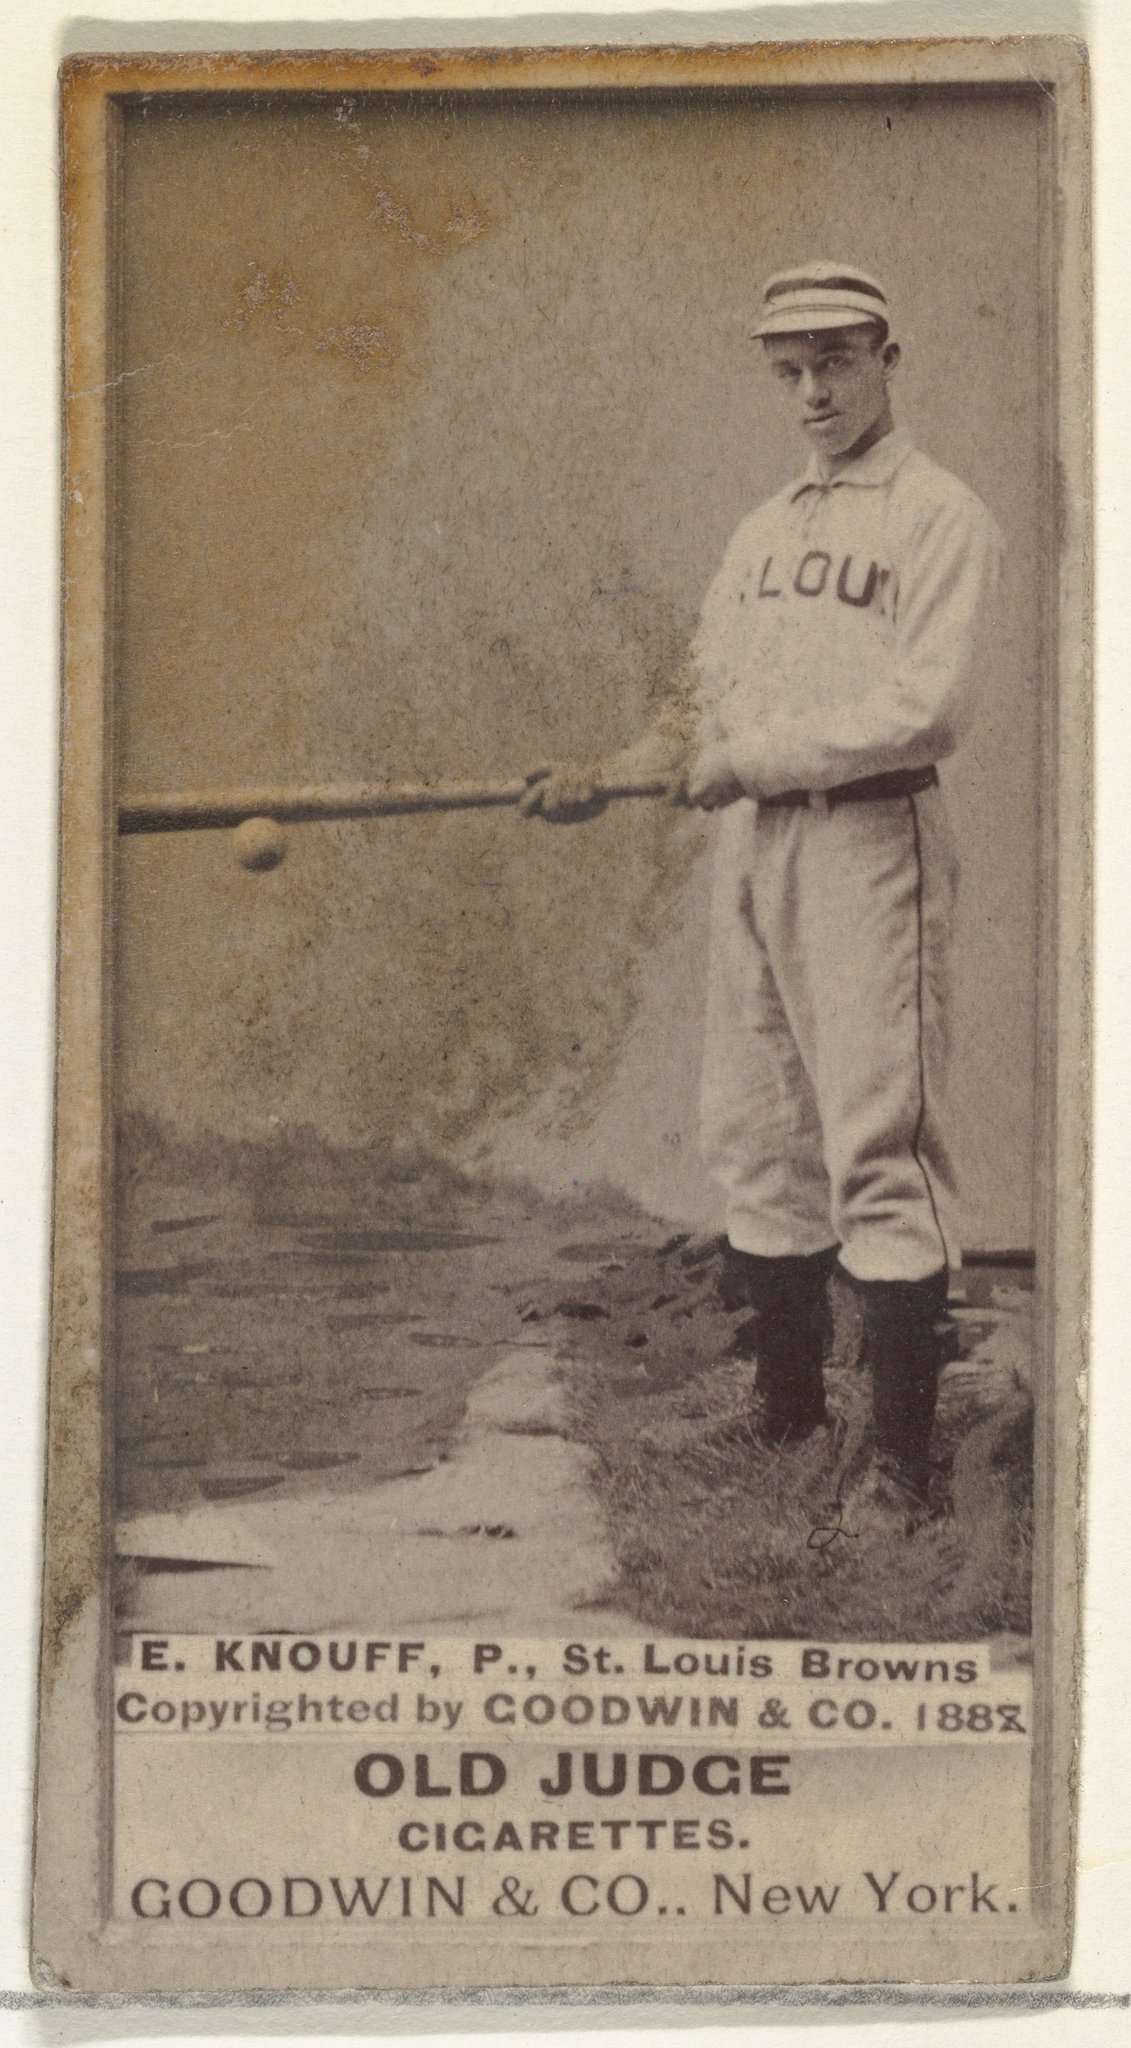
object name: baseball card, photograph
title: Edward Augustine "Ed" Knouff, Pitcher, St. Louis Browns, from the Old Judge series (N172) for Old Judge Cigarettes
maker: goodwin & company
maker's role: publisher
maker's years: 1850-1950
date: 1888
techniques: albumen silver print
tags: men,portraits,baseball,athletes